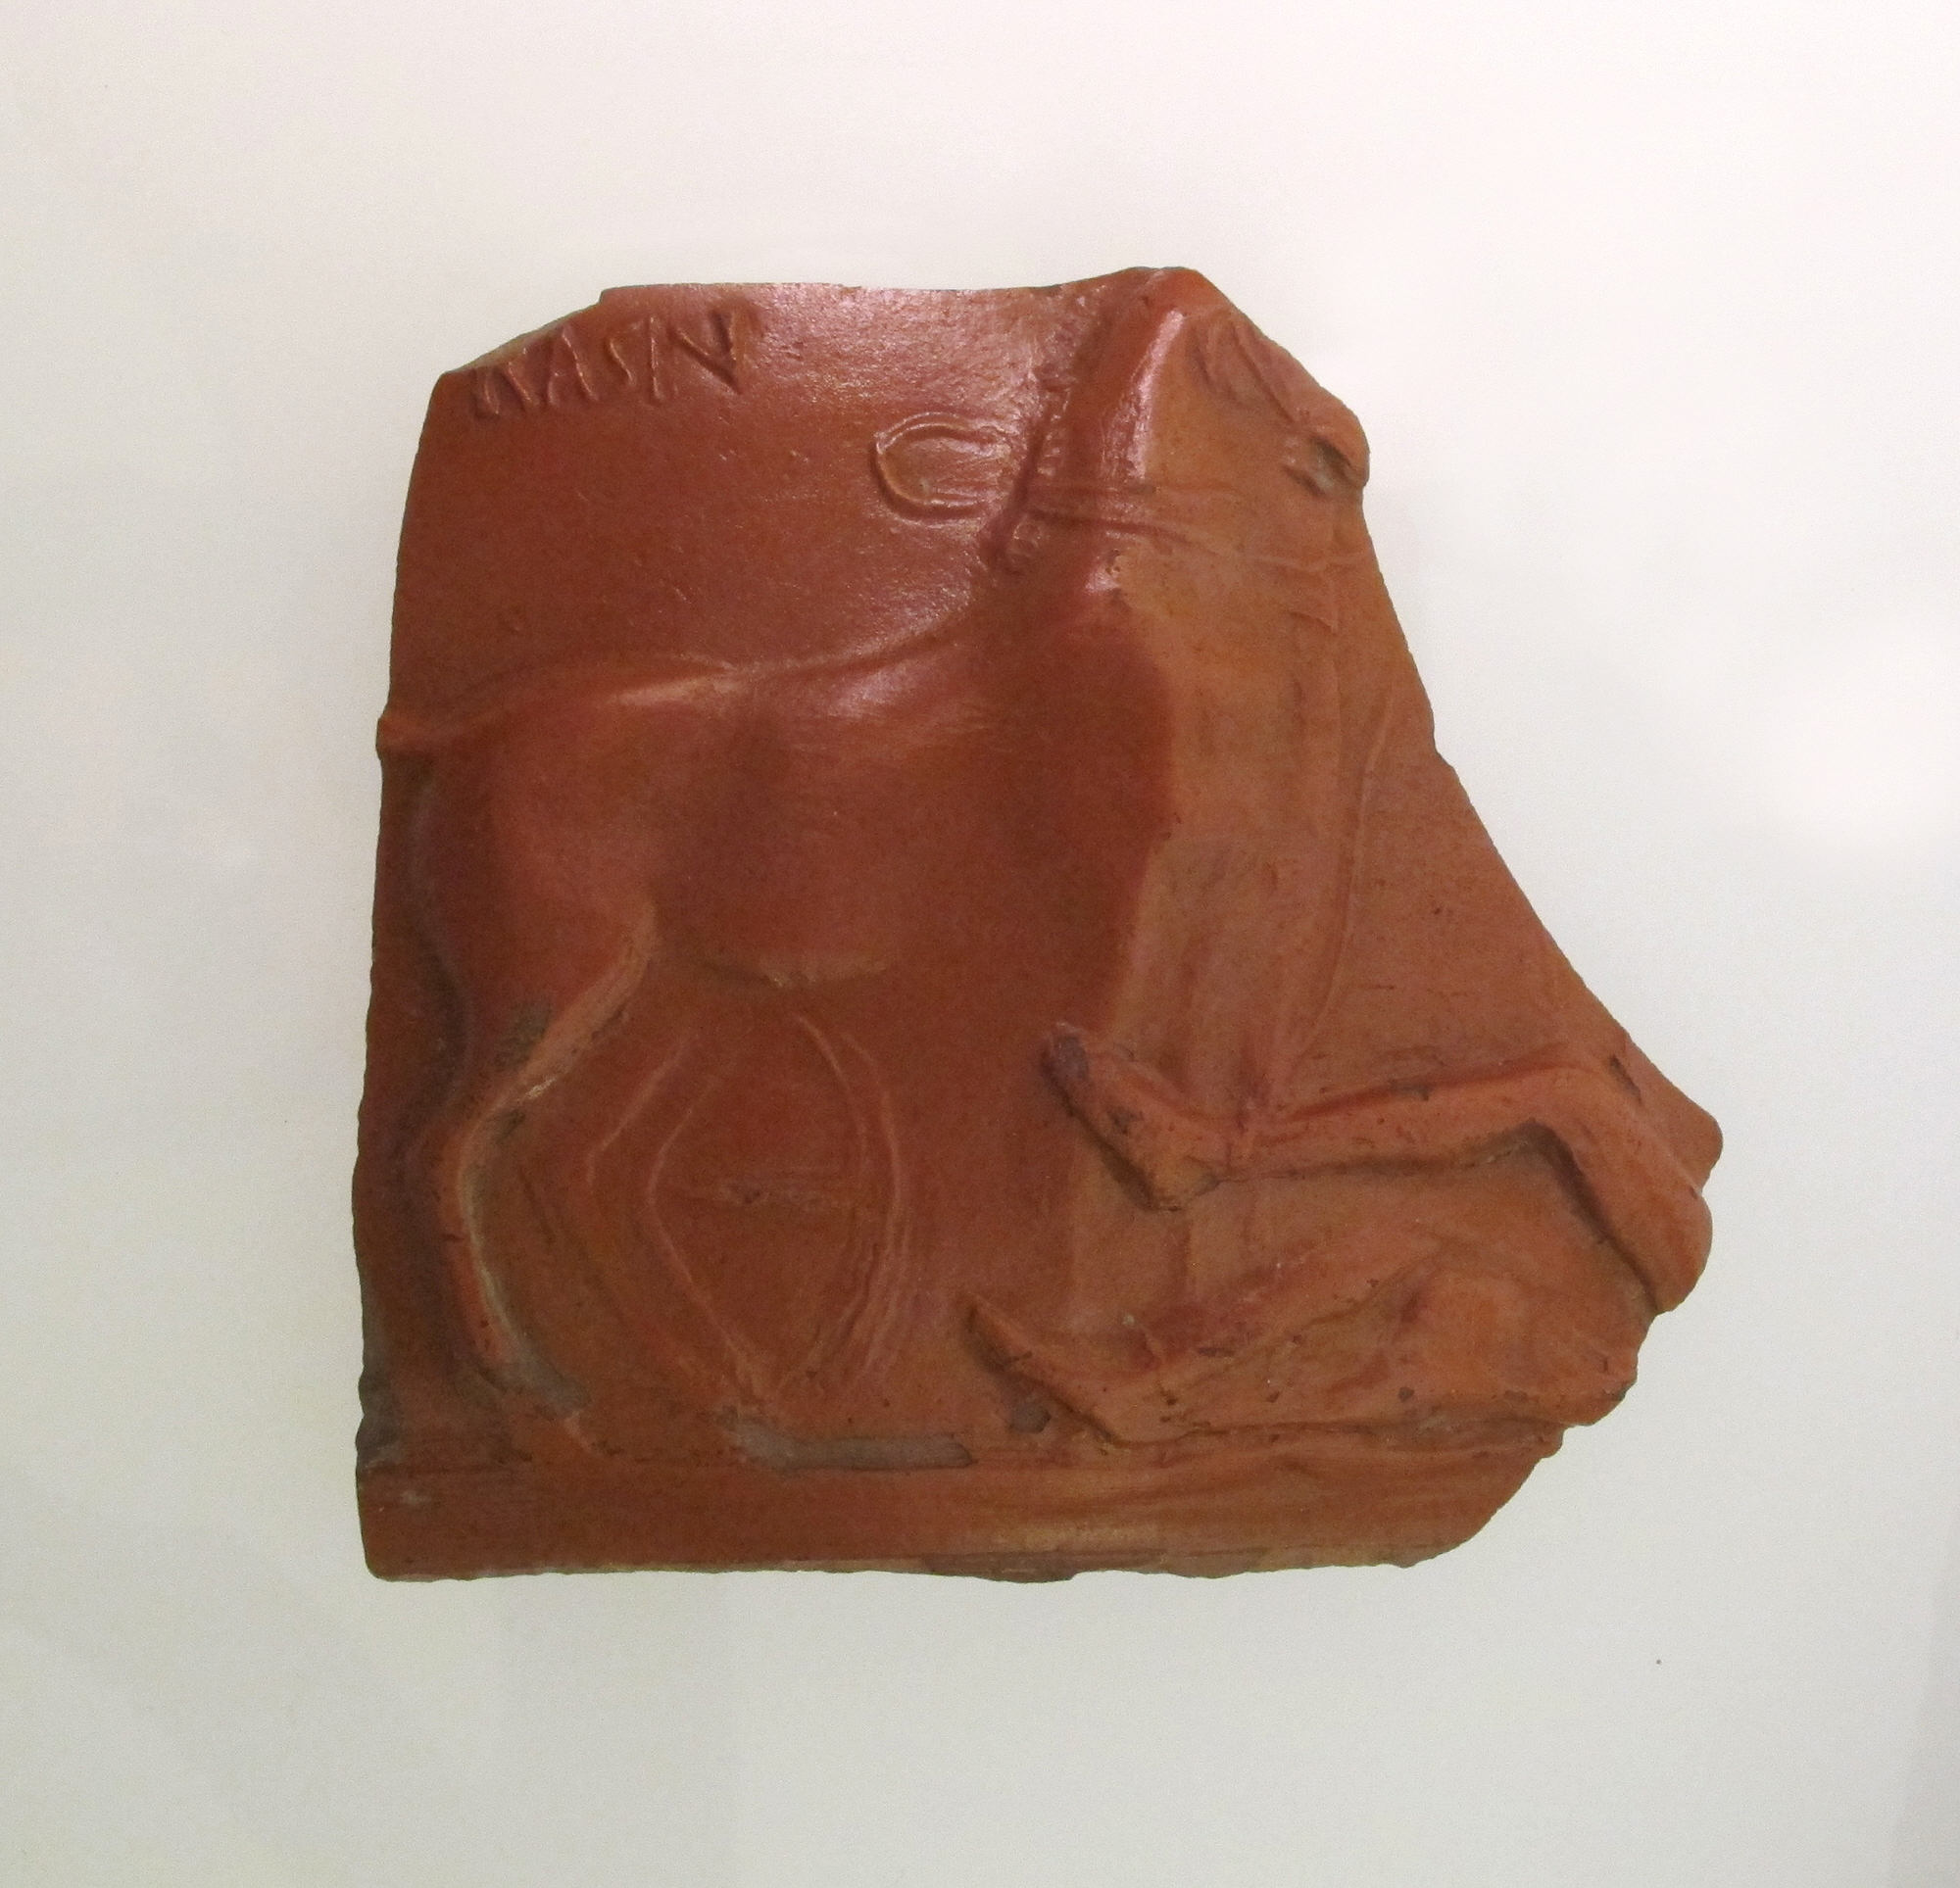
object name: vase fragment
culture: roman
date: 100 BCE-100 CE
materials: terracotta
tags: horses